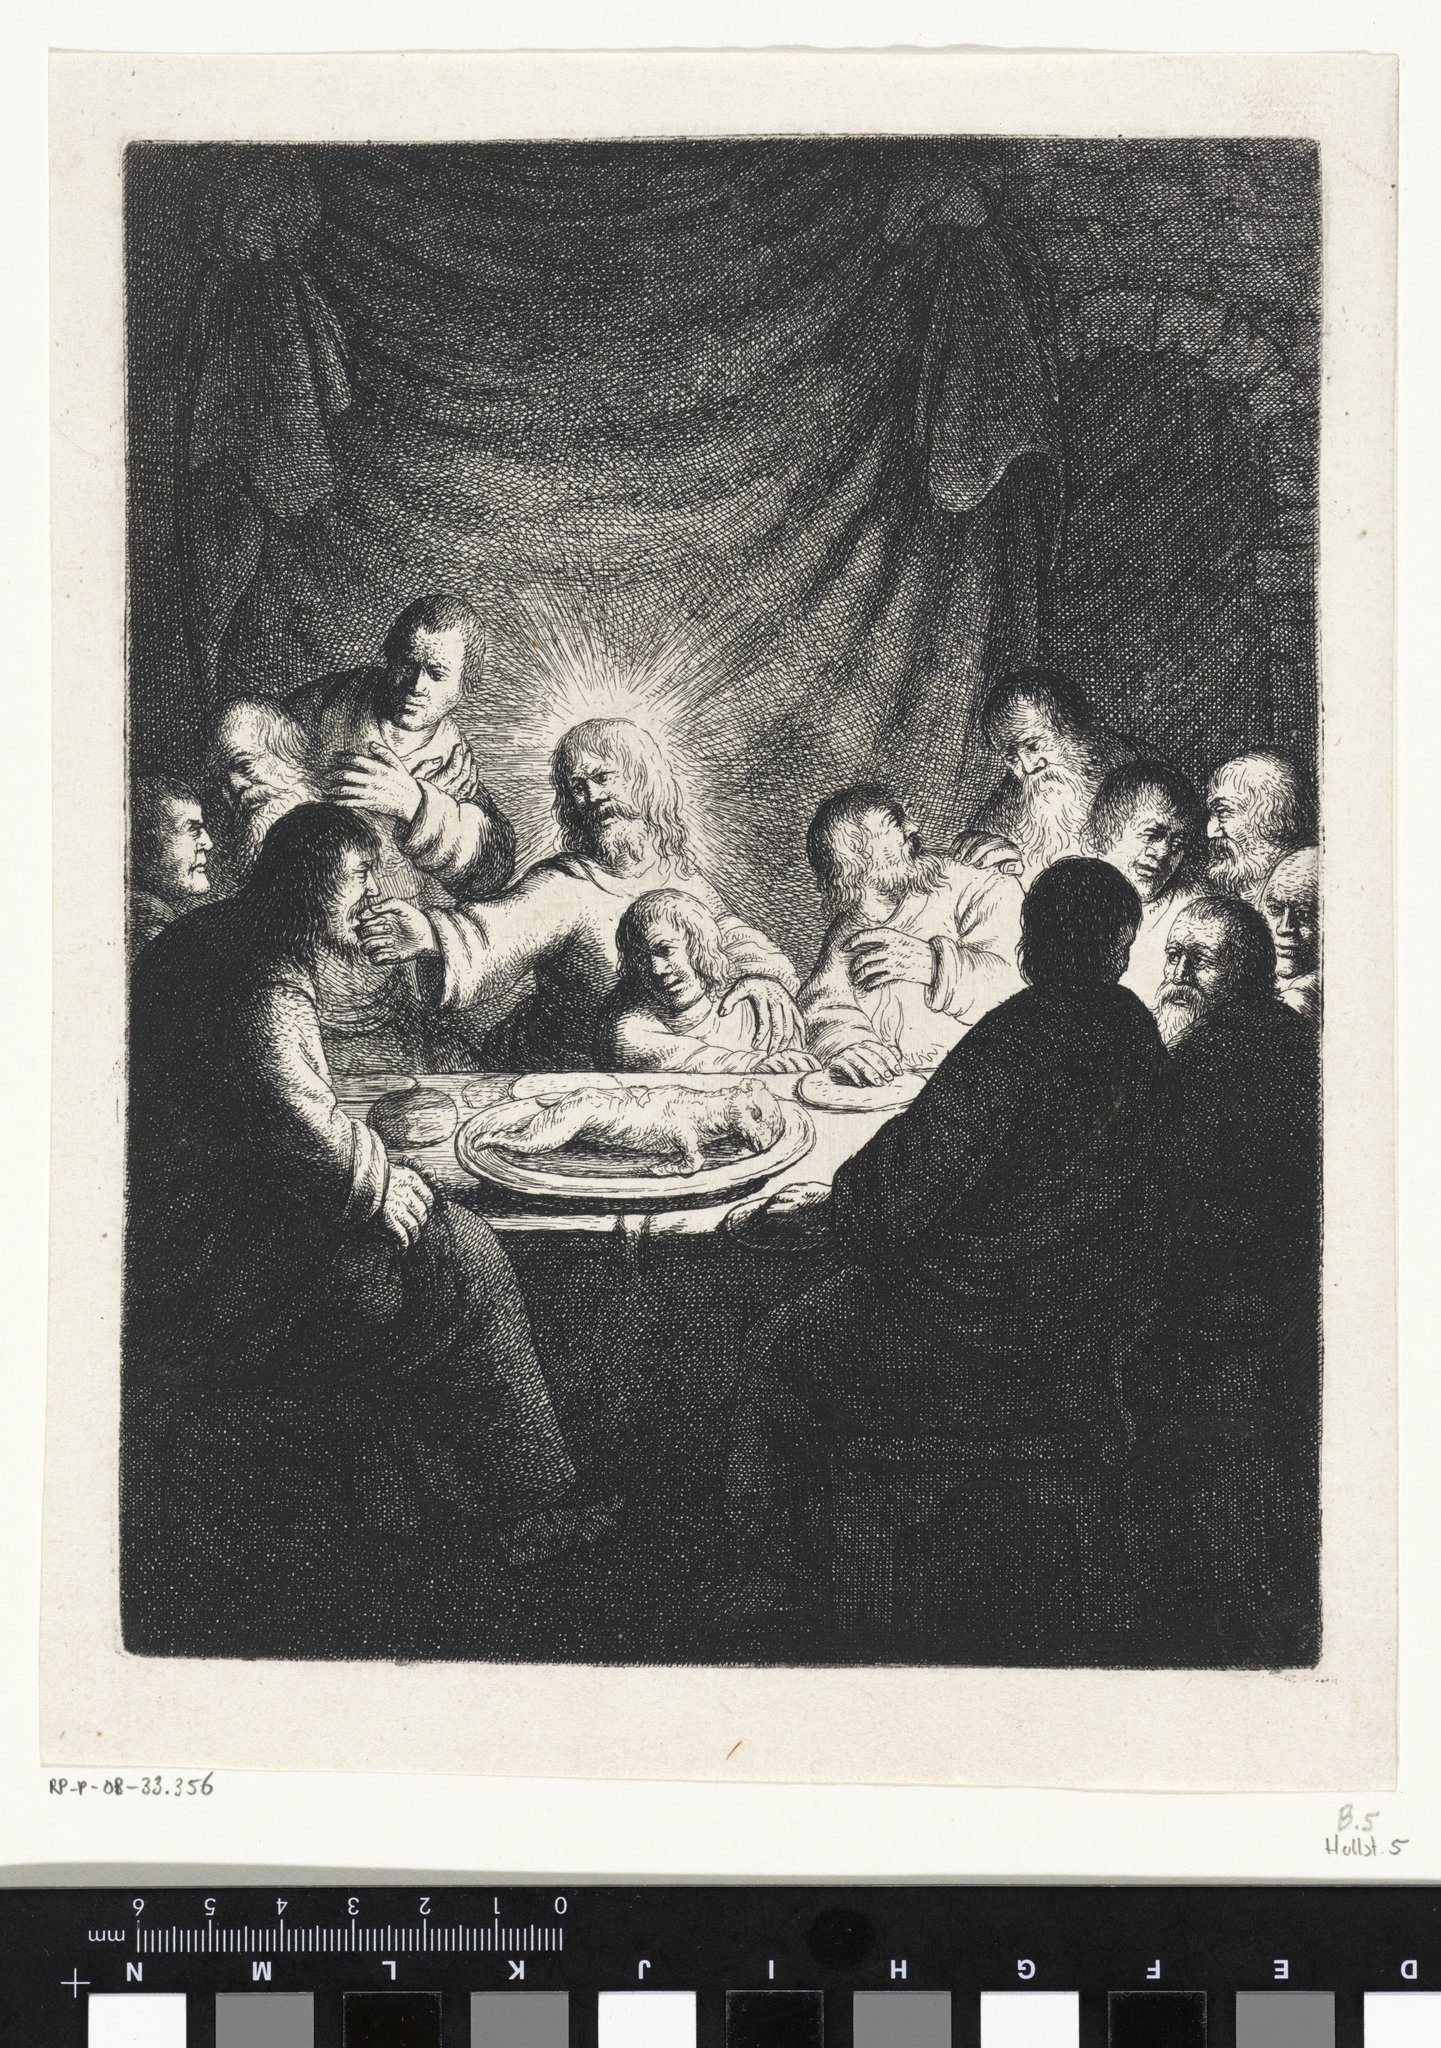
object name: print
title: Passie van Christus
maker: jan gillisz. van vliet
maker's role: draughtsman, painter, print maker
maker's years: 1600-1668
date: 1628-1637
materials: paper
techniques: engraving, etching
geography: leiden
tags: last supper (in general) (matthew 26:21-35; mark 14:18-31; luke 22:3, 22:15-23; john 13:21-38)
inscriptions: collector's mark: Lugt 240